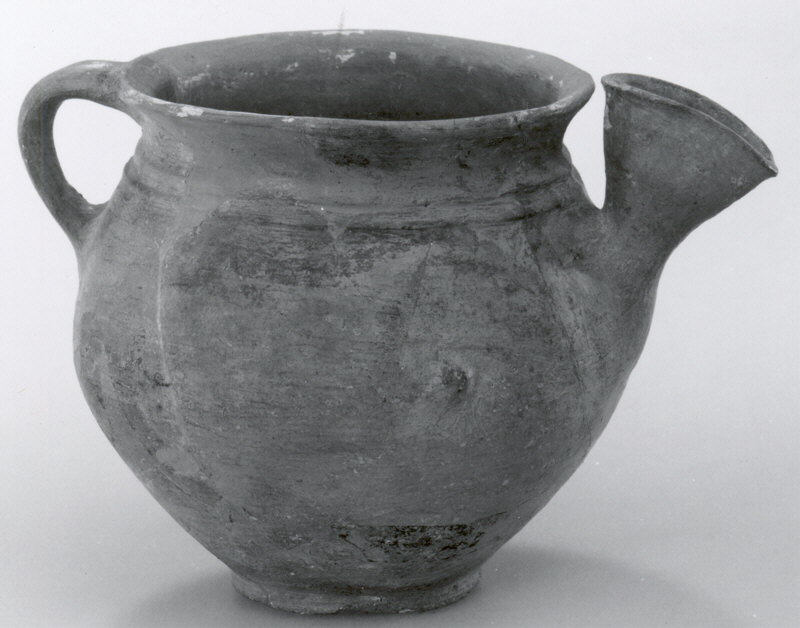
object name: jar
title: Spouted jar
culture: iranian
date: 700-601 BCE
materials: ceramic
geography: iran